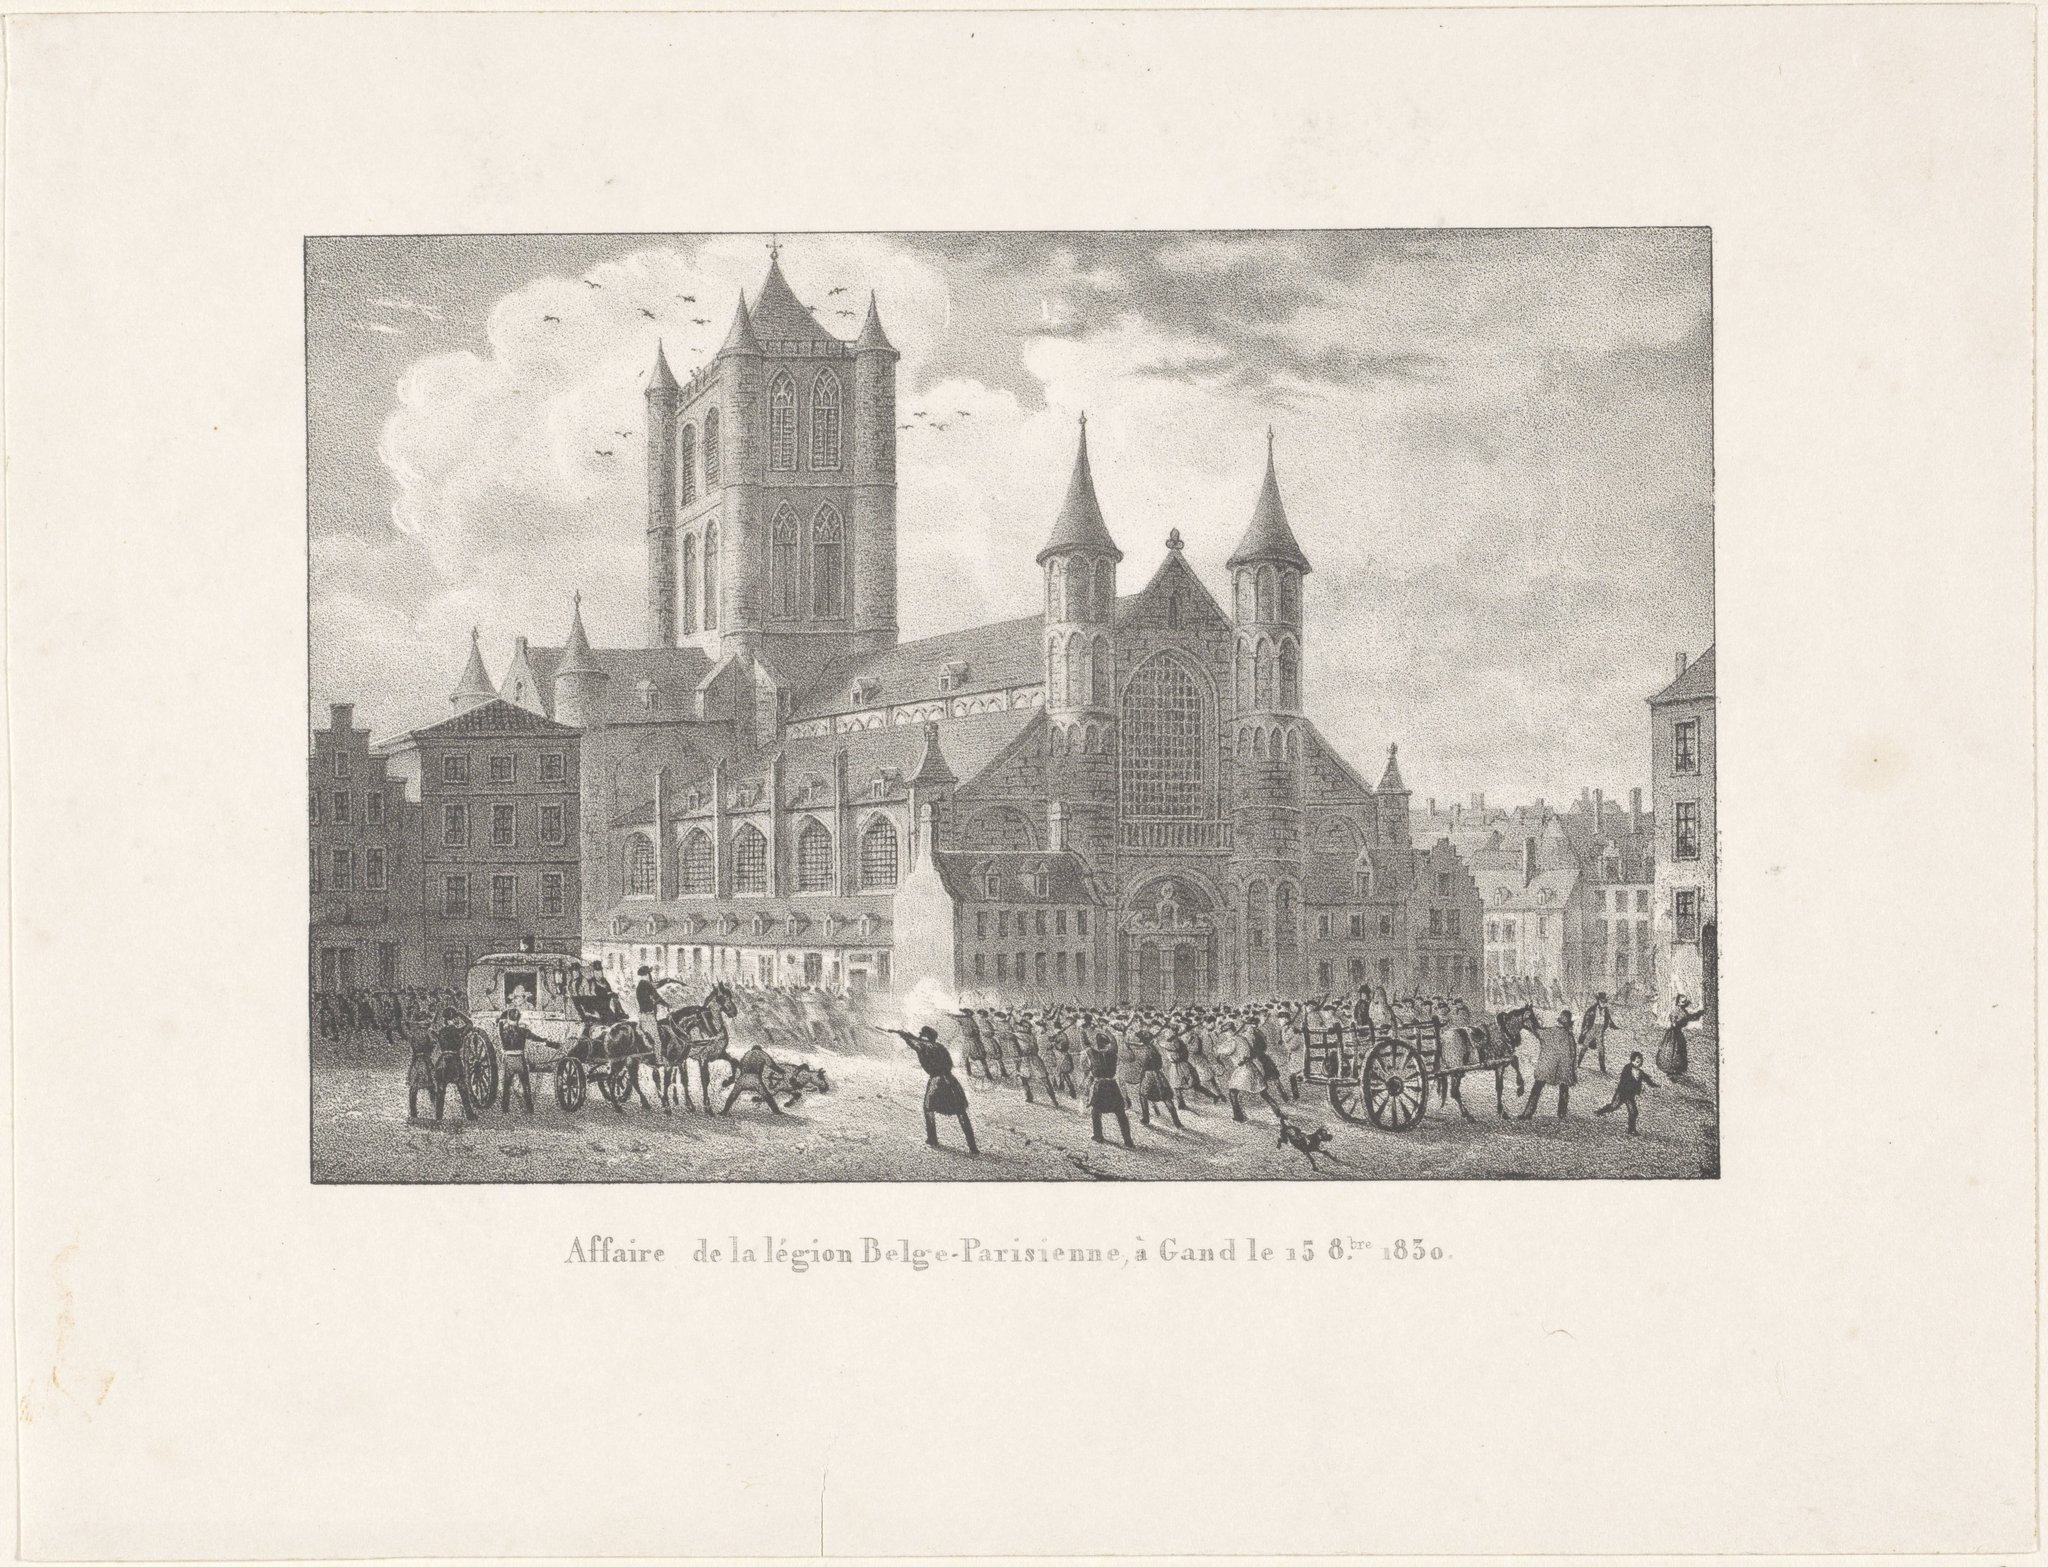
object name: print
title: Légion belge parisienne in Gent, 1830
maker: Anonymous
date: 1835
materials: paper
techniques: lithograph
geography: brussels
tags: street-fights, riots, ghent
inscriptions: collector's mark: Lugt 2228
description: Deze prent is gedrukt van dezelfde steen als “Voyage pittoresque dans le Royaume des Pays-Bas” (gedrukt door Jobard, 1825), getekend door Lt. Generaal Otto Baron Howen, op steen gebracht door Jean Baptiste Madou. De steen is in 1835 nog in ongewijzigde staat gebruikt voor de herdruk. Door Muller ingedeeld bij de serie 'Evénemens de Bruxelles' maar behoort eigenlijk tot een andere serie.